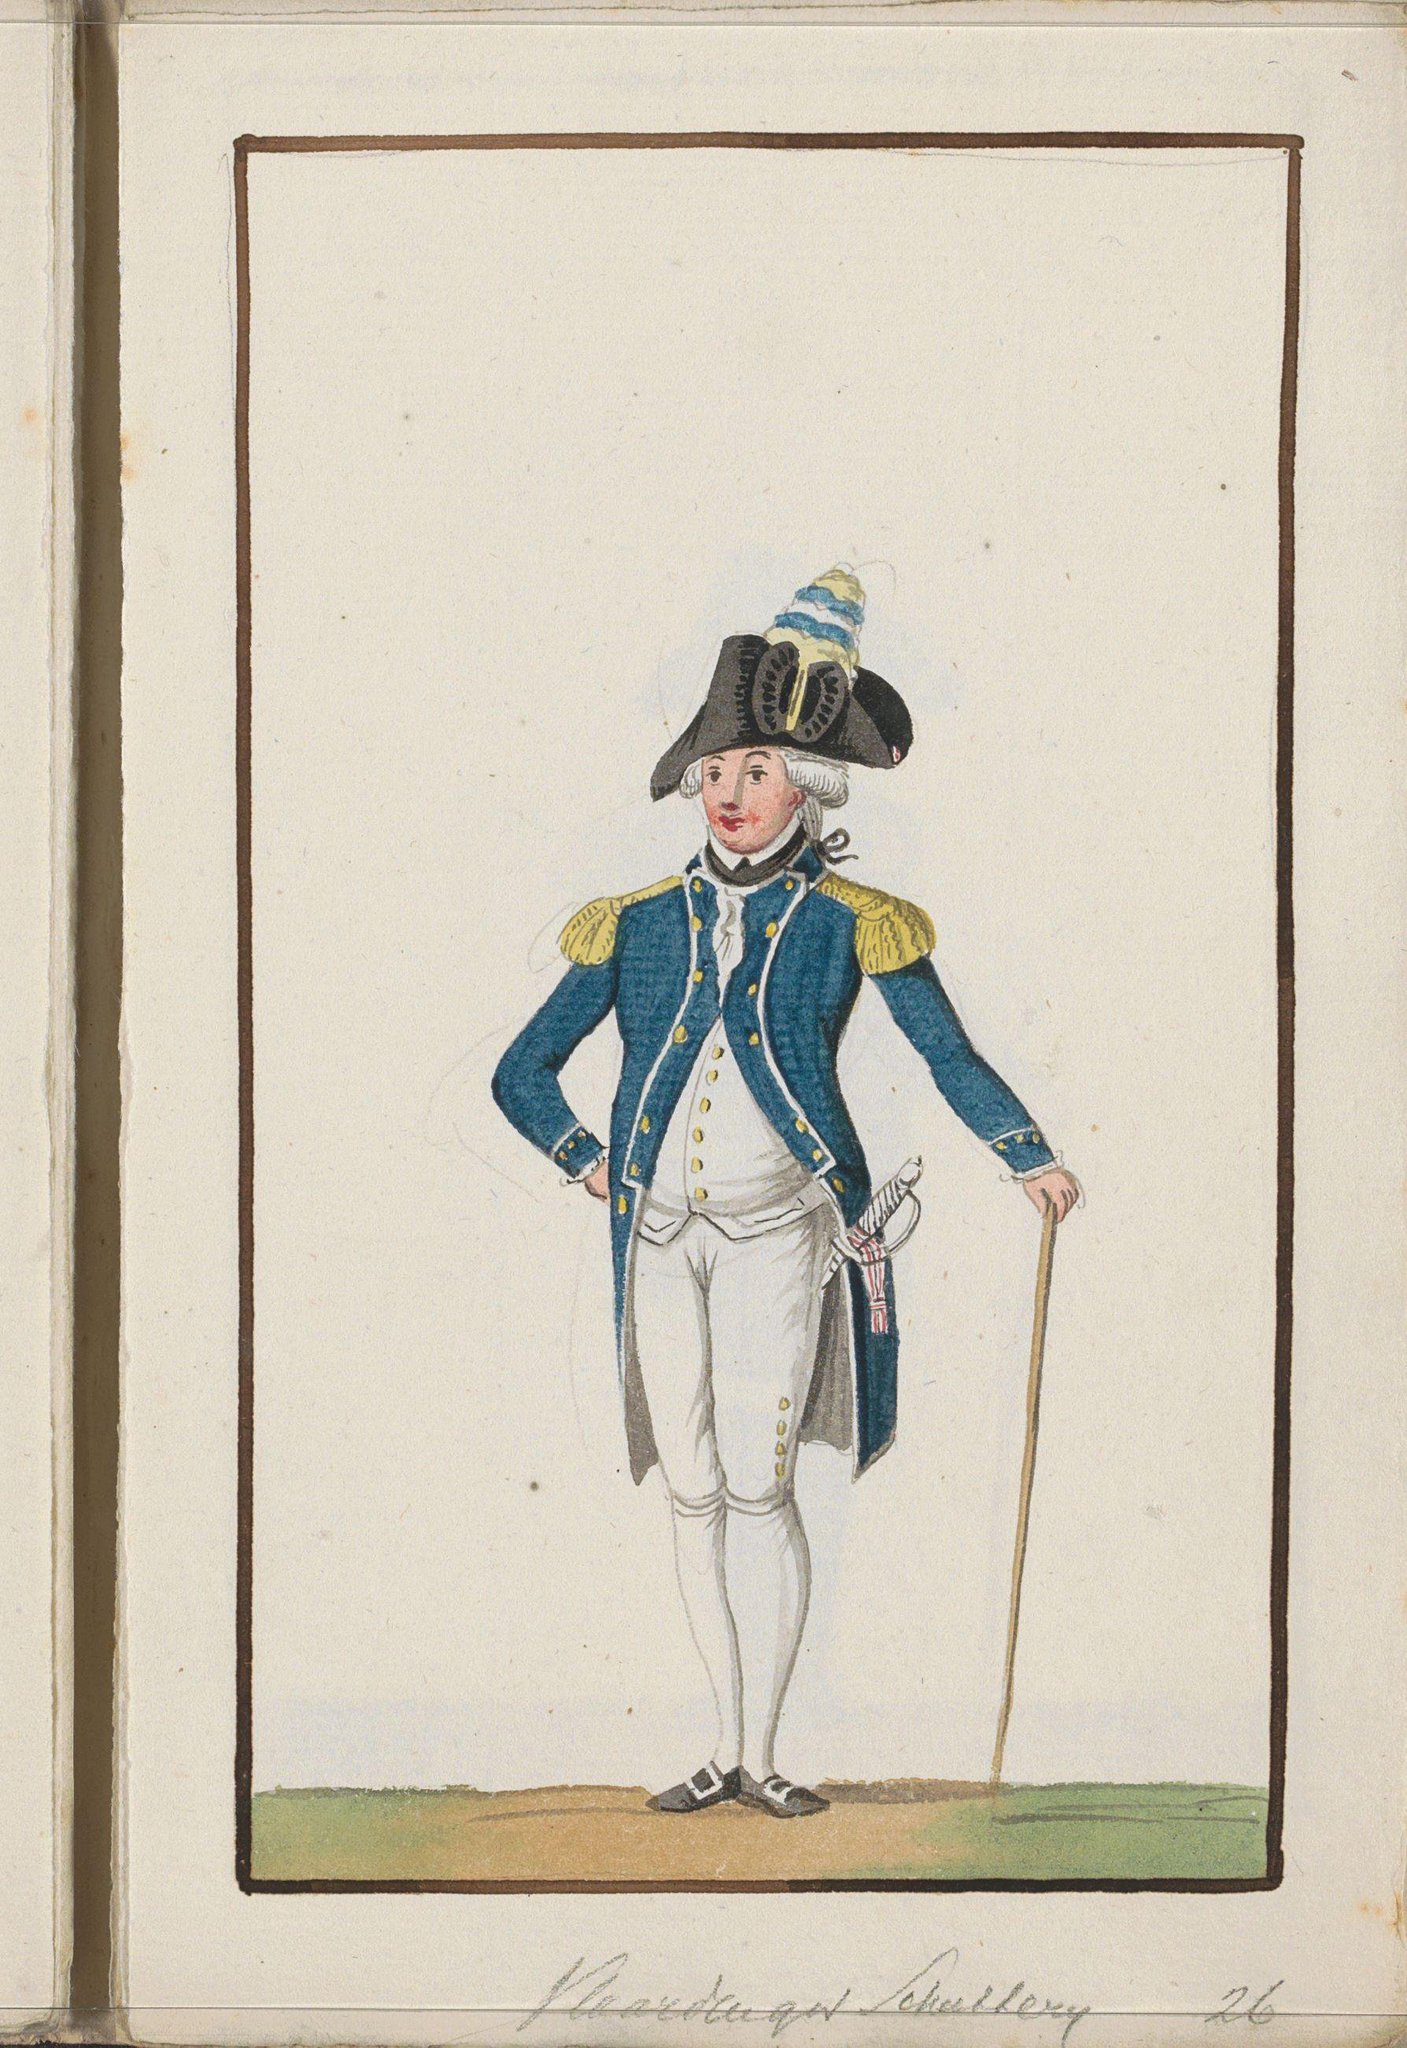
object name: drawing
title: Montering van schutterij van Vlaardingen, ca. 1785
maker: Anonymous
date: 1789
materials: paper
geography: northern netherlands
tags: (military) uniforms (+ citizen soldiery, civil guard, citizen militia), patriots (1780-1795)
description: Montering of uniform van de schutterij van Vlaardingen, ca. 1785. Onderdeel van een schetsboek met 41 gekleurde tekeningen van de monteringen van de gewapende schutterijen en burgercorpsen in Nederland in de periode ca. 1783-1789.